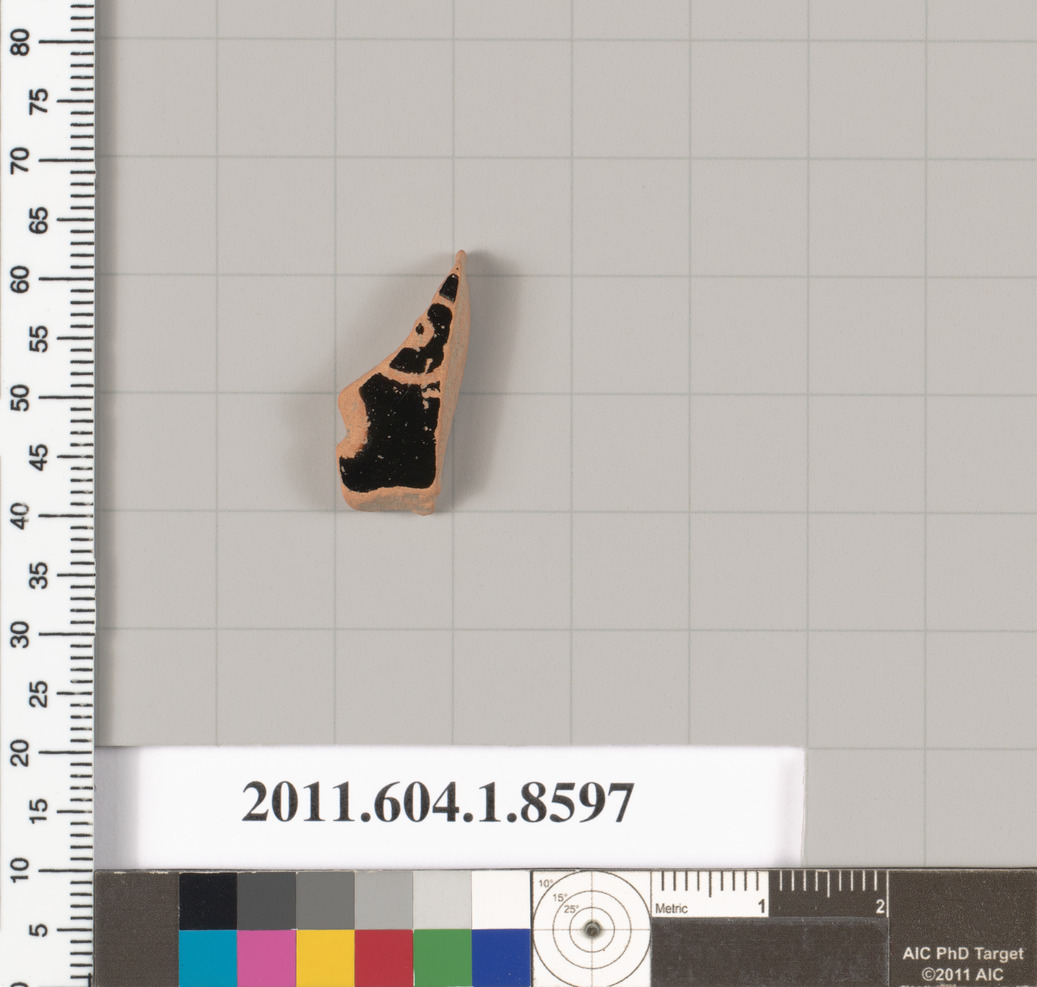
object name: kylix fragment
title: Terracotta fragment of a stemless kylix (drinking cup)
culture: greek, attic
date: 470-450 BCE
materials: terracotta